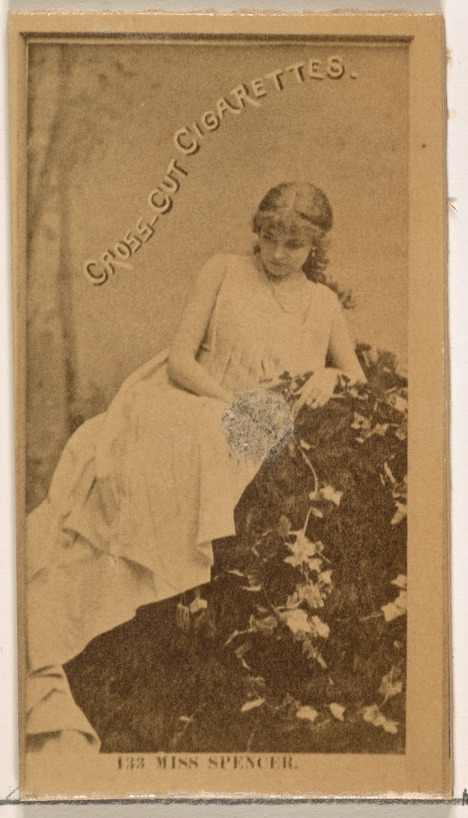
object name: print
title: Card Number 133, Miss Spencer, from the Actors and Actresses series (N145-2) issued by Duke Sons & Co. to promote Cross Cut Cigarettes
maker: w. duke, sons & co.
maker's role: publisher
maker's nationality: american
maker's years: 1870-1920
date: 1880-1889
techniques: albumen silver print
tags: portraits,women,actresses